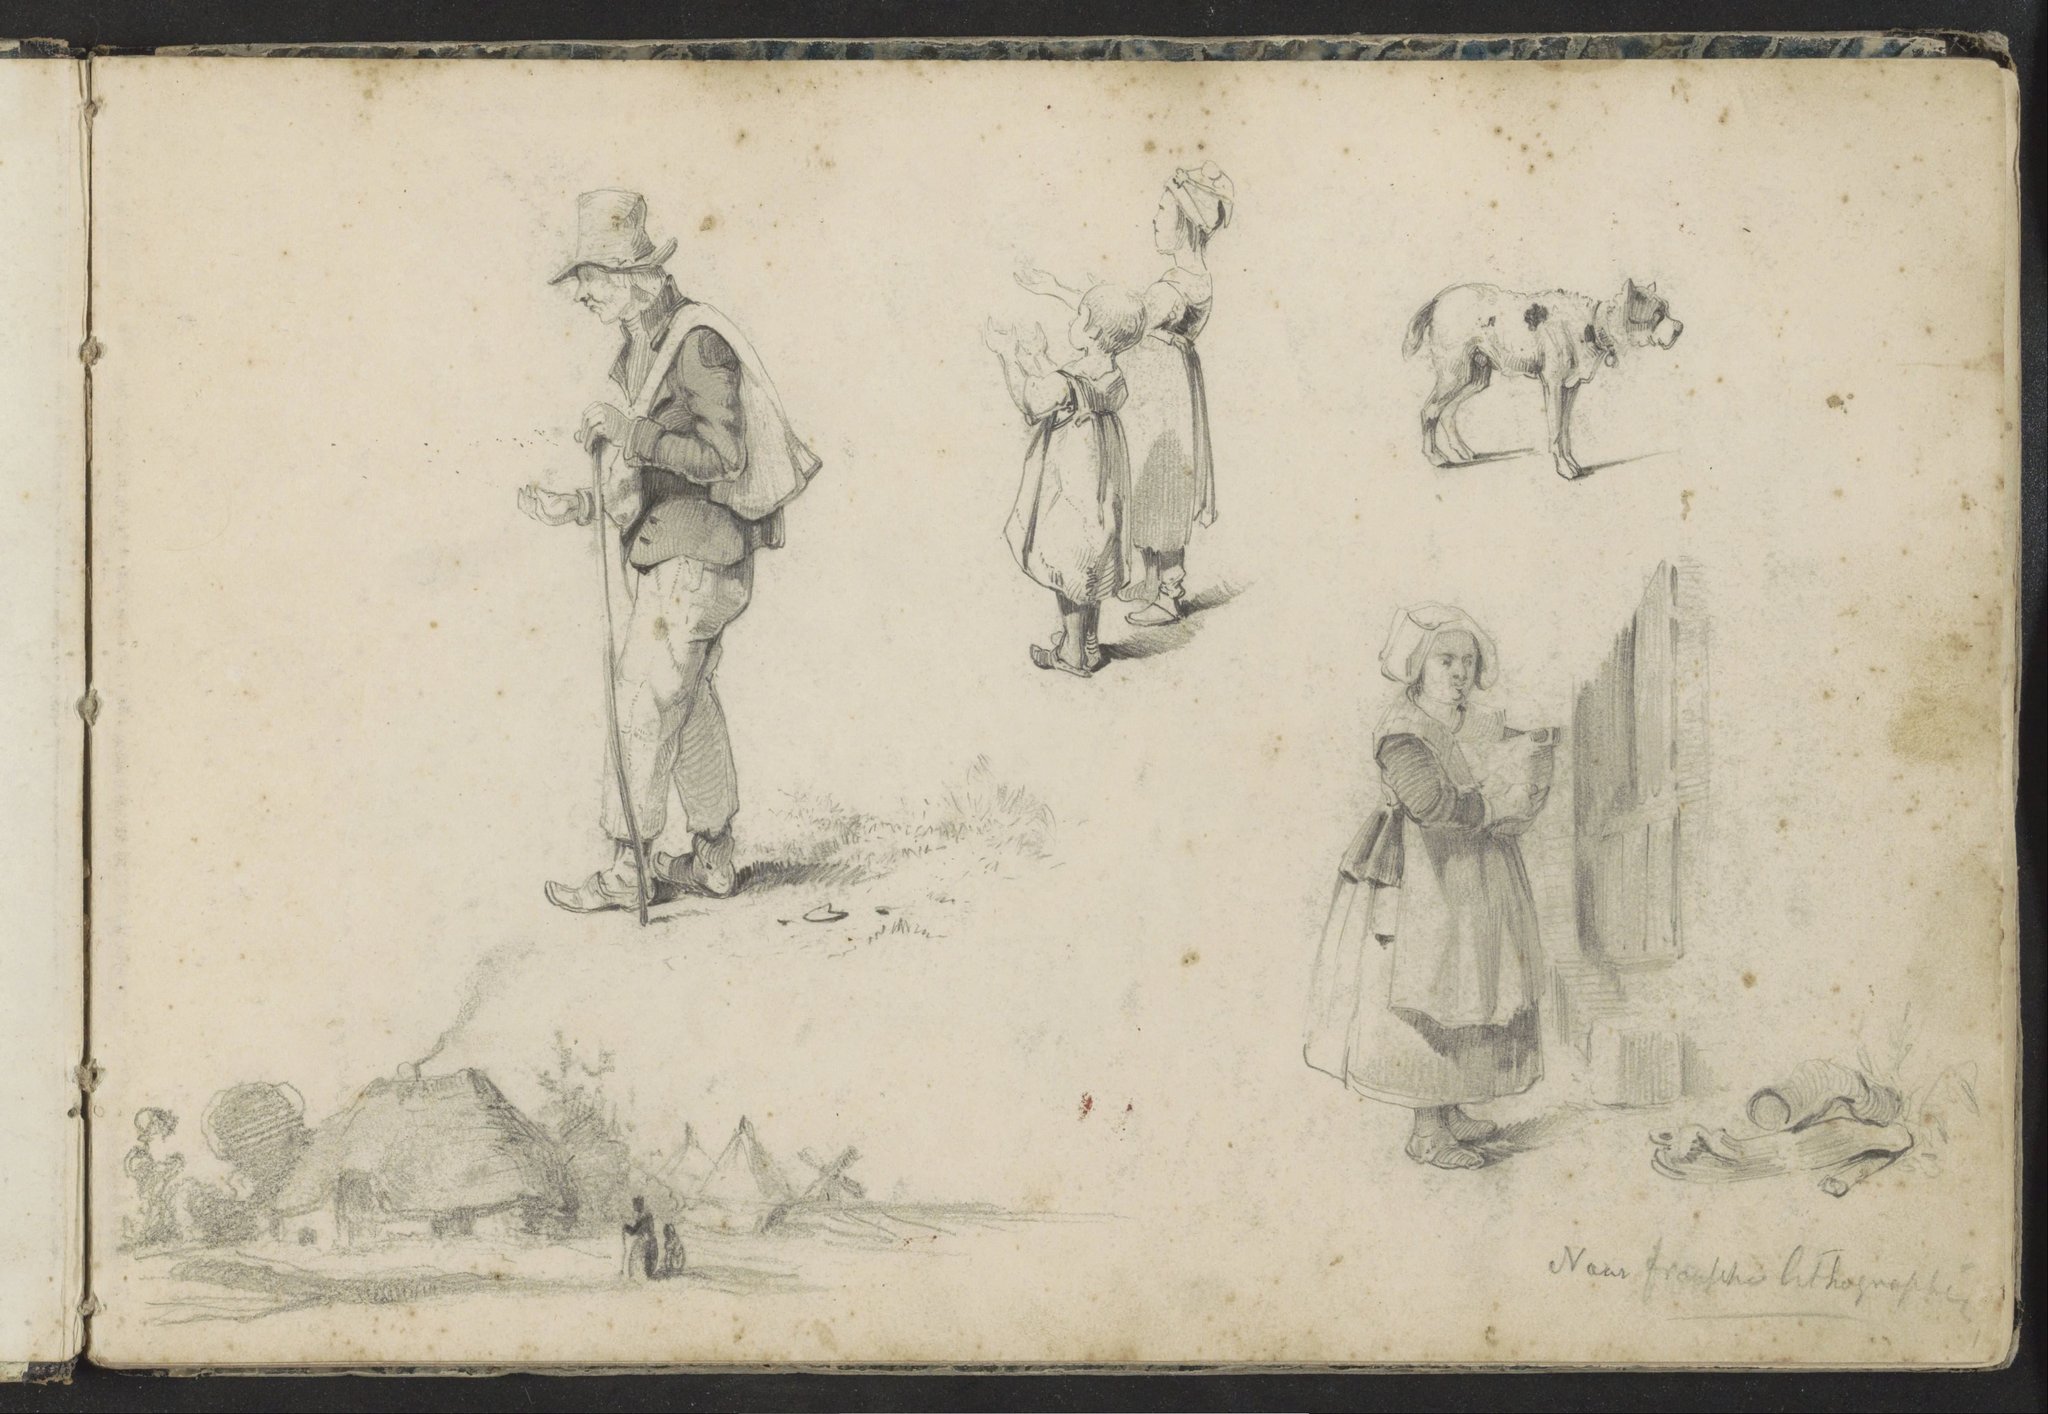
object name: sketchbook leaf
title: Boerderij, boeren en een hond naar Franse lithografieën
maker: johannes tavenraat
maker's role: draughtsman, painter, print maker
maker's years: 1809-1881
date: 1843-1857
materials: paper, pencil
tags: farmers, farm (building), dog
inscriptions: annotation: ‘Naar fransche Lithographen’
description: Blad 1 recto uit een schetsboek met 44 bladen.